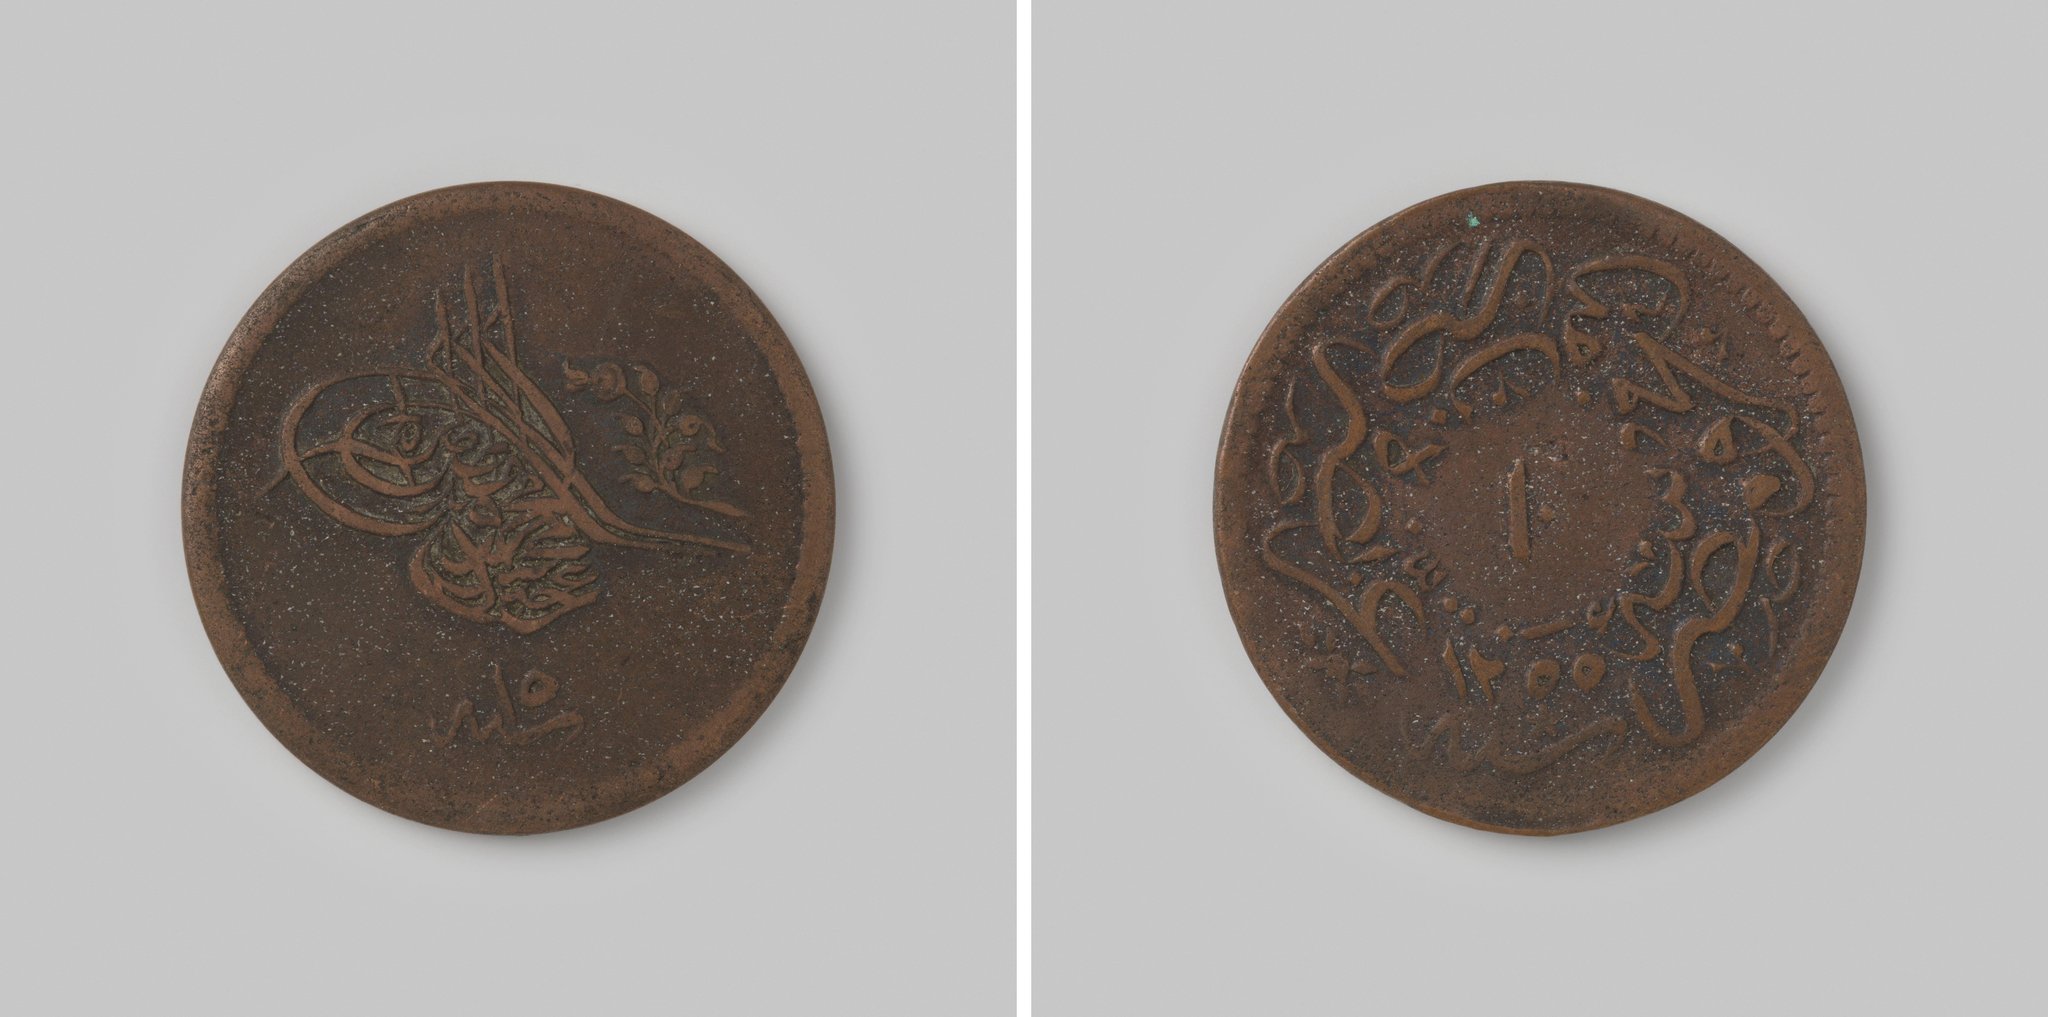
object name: coin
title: Egypte, Ottomaanse sultan Abdul Mejid, 5 para,1269 [=1852]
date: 1851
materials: copper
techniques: striking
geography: cairo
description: Koperen munt. Voorzijde: tughra met rechts daarvan tak met bladeren. Onder de tughra cijfer: 15 [=regeringsjaar]. Keerzijde: omschrift in Arabische letters: zuriba fi Misr [=Egypte, Caïro]. Daarbinnen waarde-aanduiding:10 en daaronder jaar van aantreden:1255.